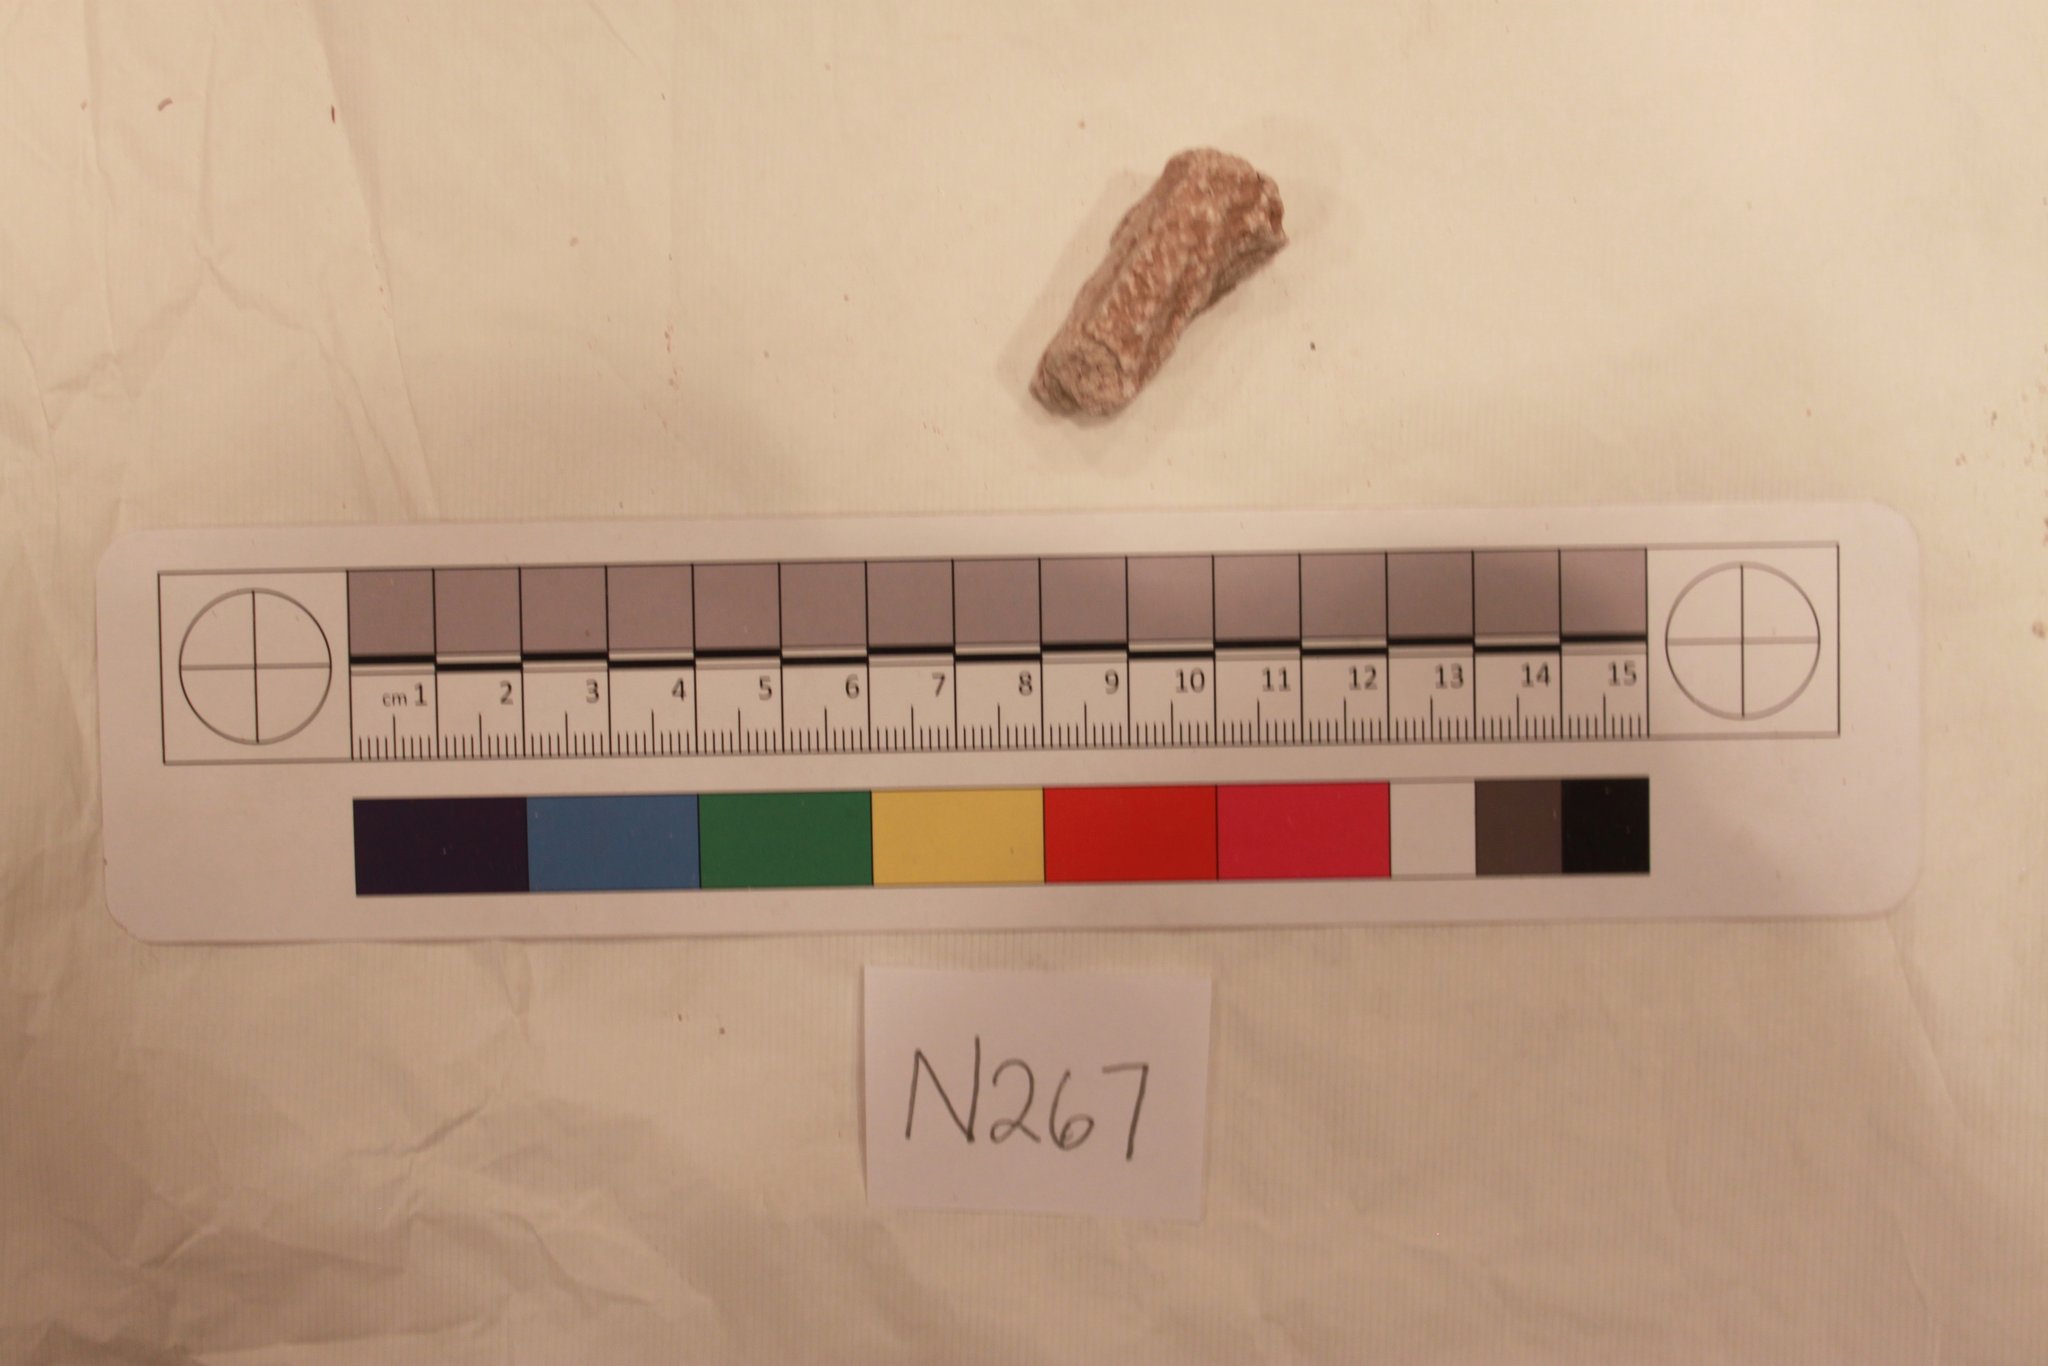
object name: fragment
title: Stucco Fragment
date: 701-1200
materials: plaster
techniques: carving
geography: iran